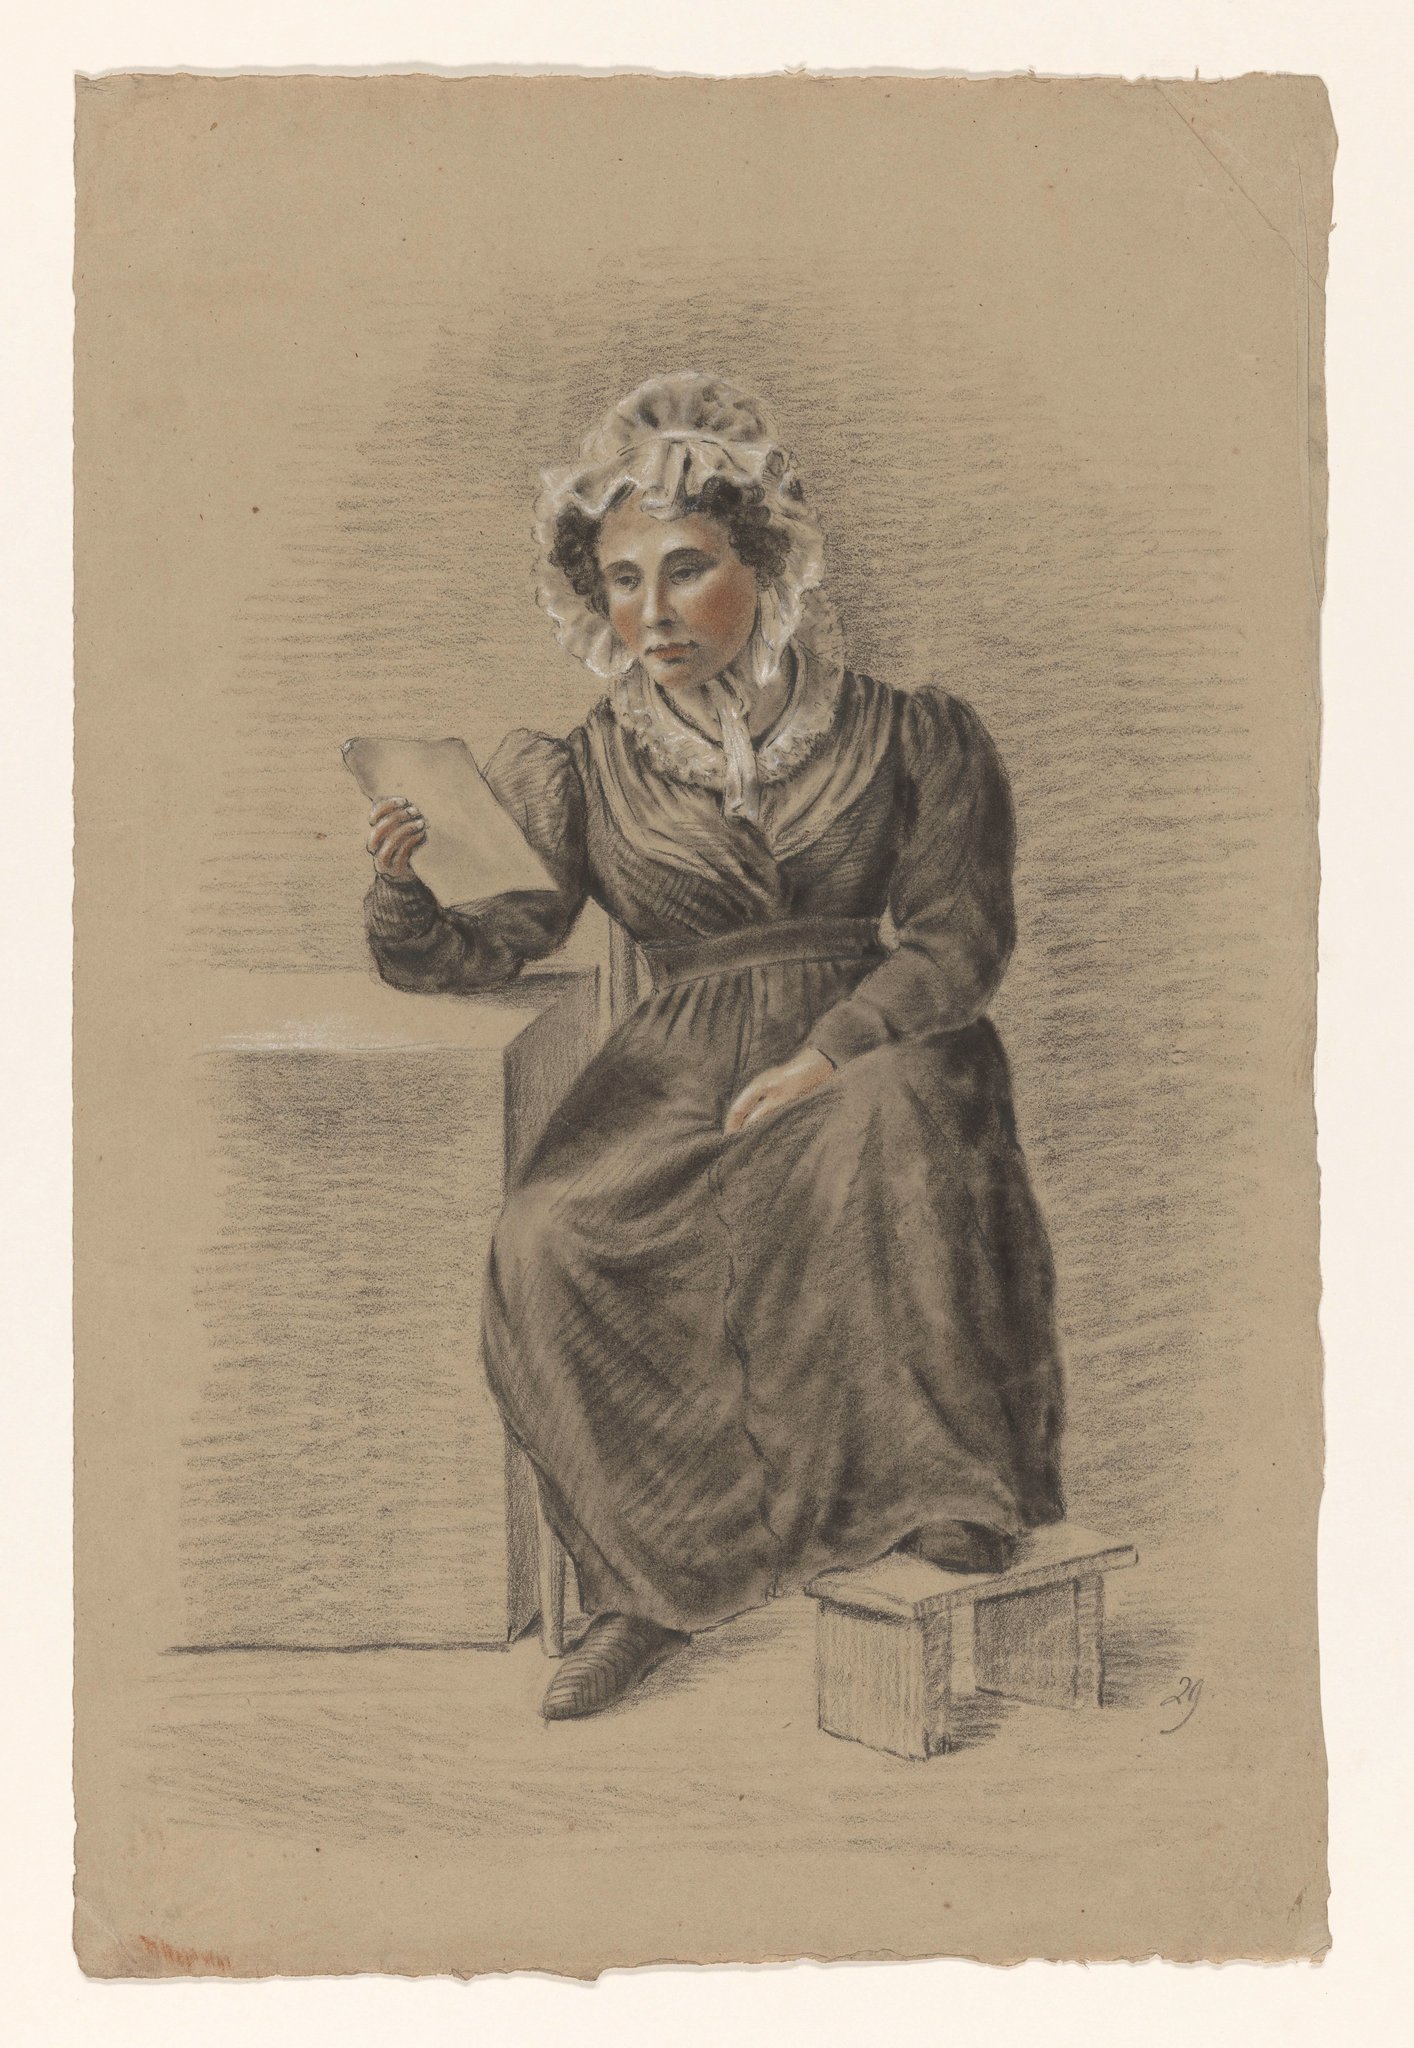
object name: drawing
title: Zittende vrouw met de voet op een stoof, een brief lezend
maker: alexander cranendoncq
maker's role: draughtsman, print maker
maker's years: 1799-1869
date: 1809-1869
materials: chalk, paper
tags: reading